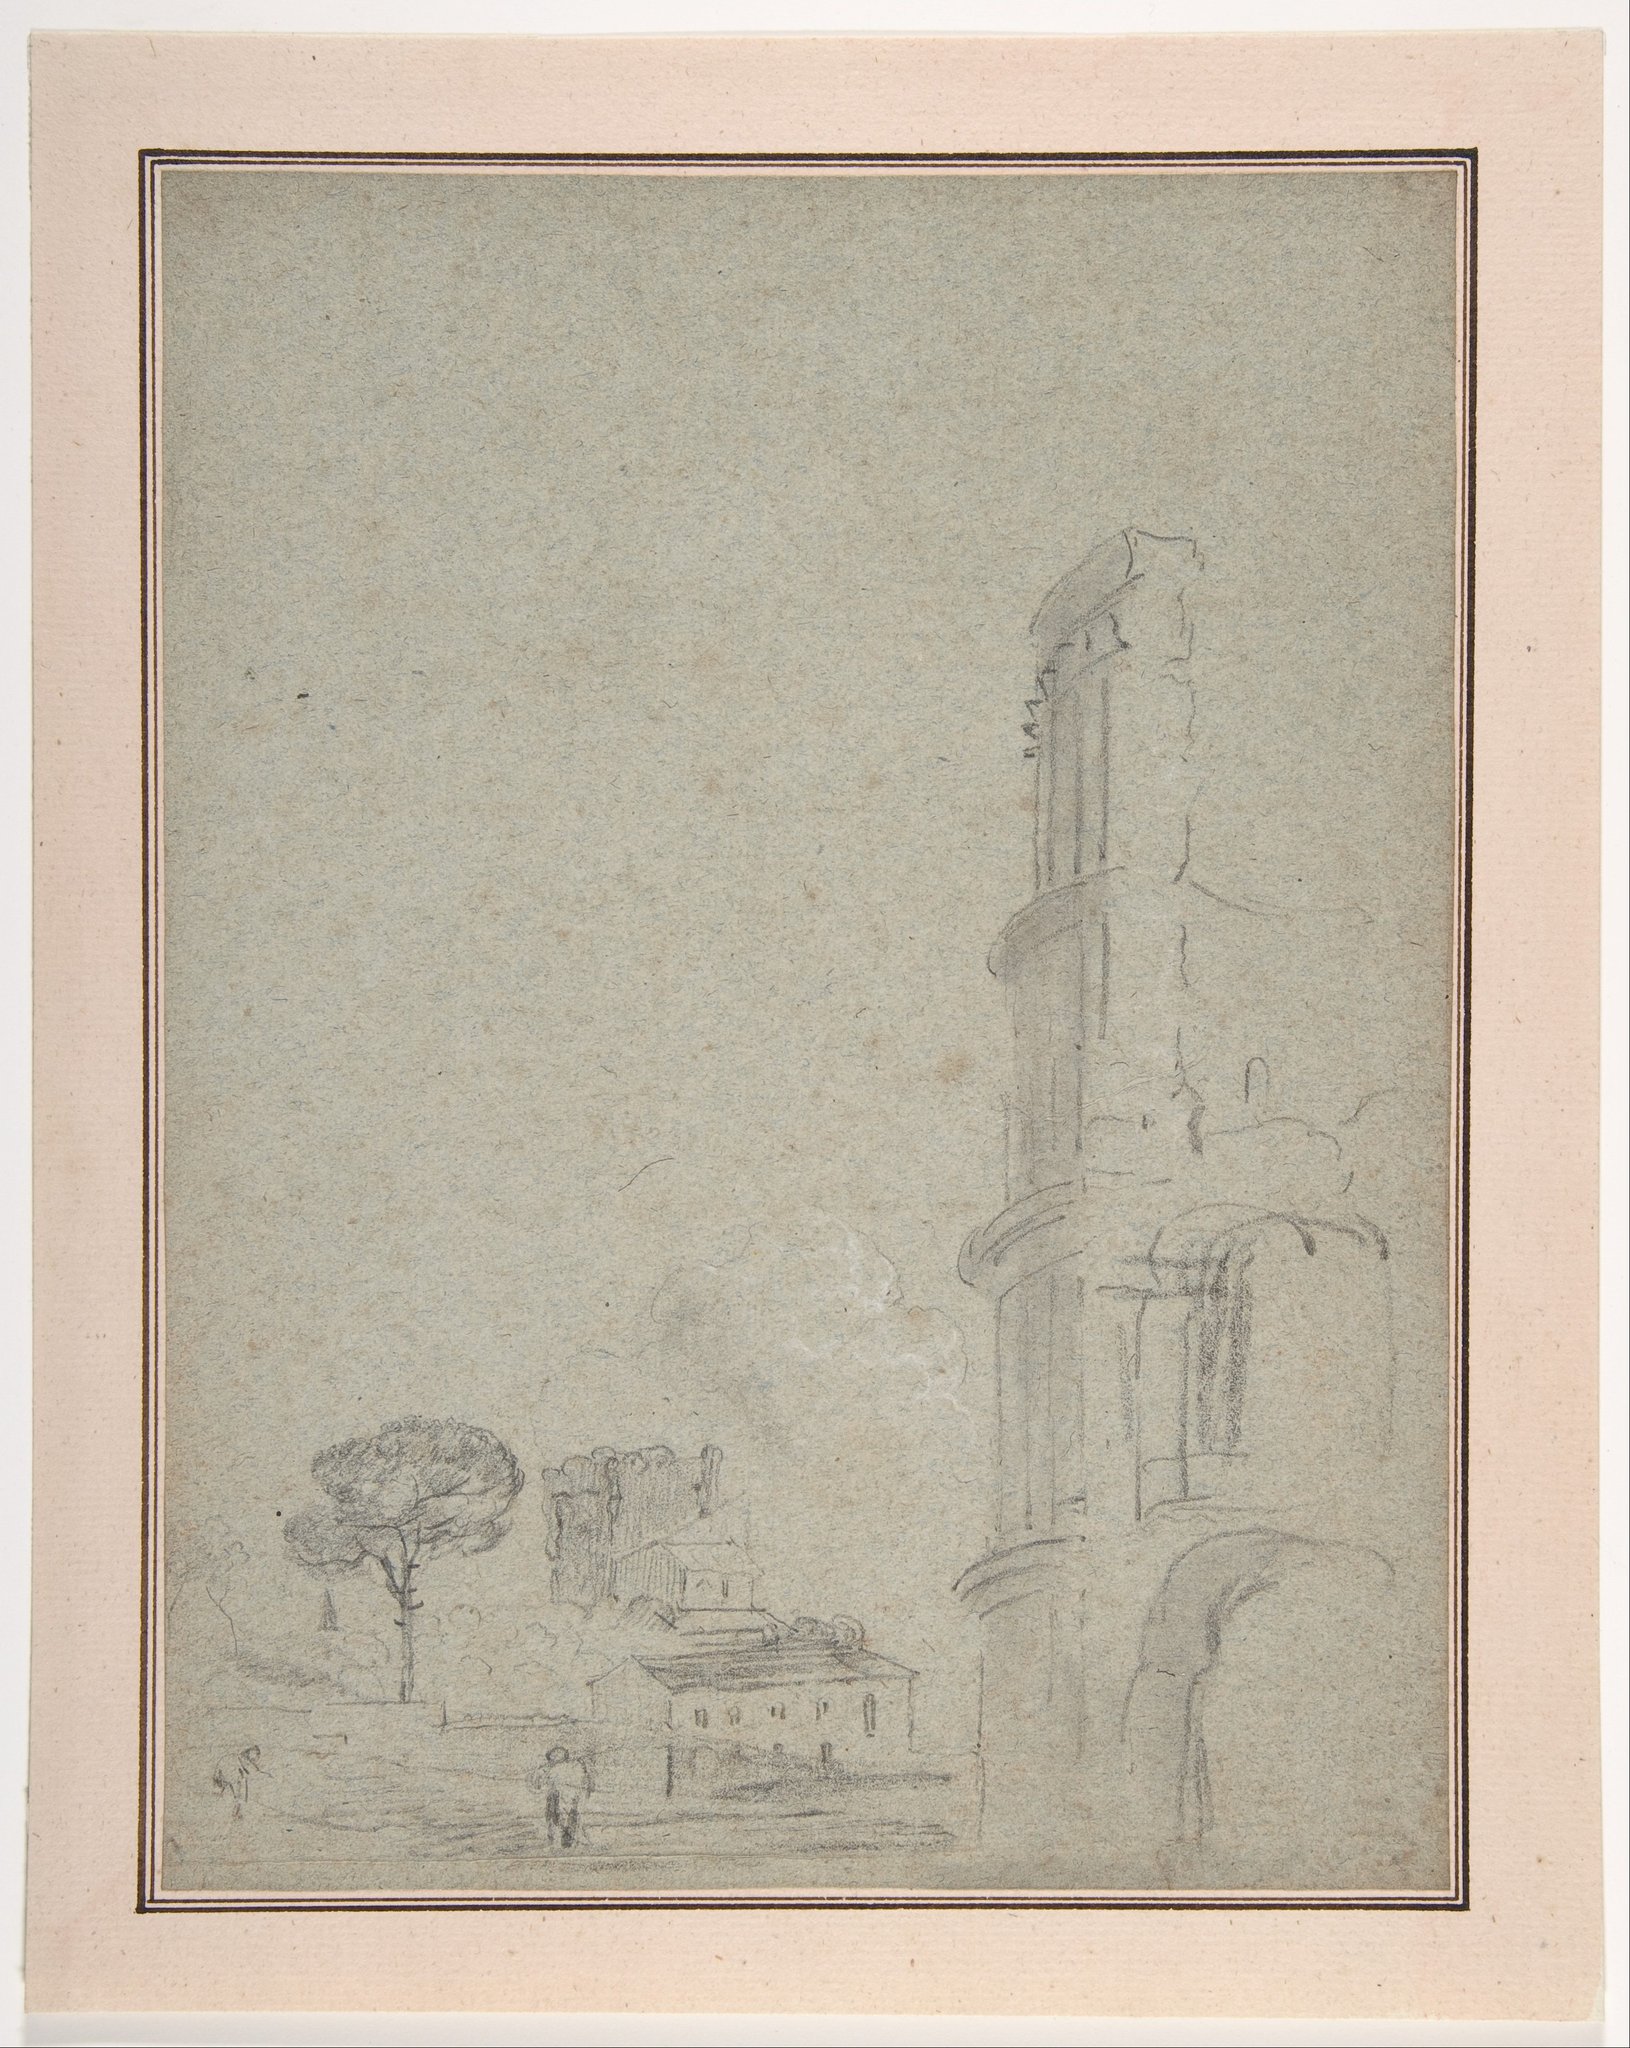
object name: drawing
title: View of the Colosseum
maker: richard wilson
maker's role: artist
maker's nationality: british, welsh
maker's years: 1714-1782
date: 1751-1756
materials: chalk, ink, paper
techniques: heightening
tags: buildings